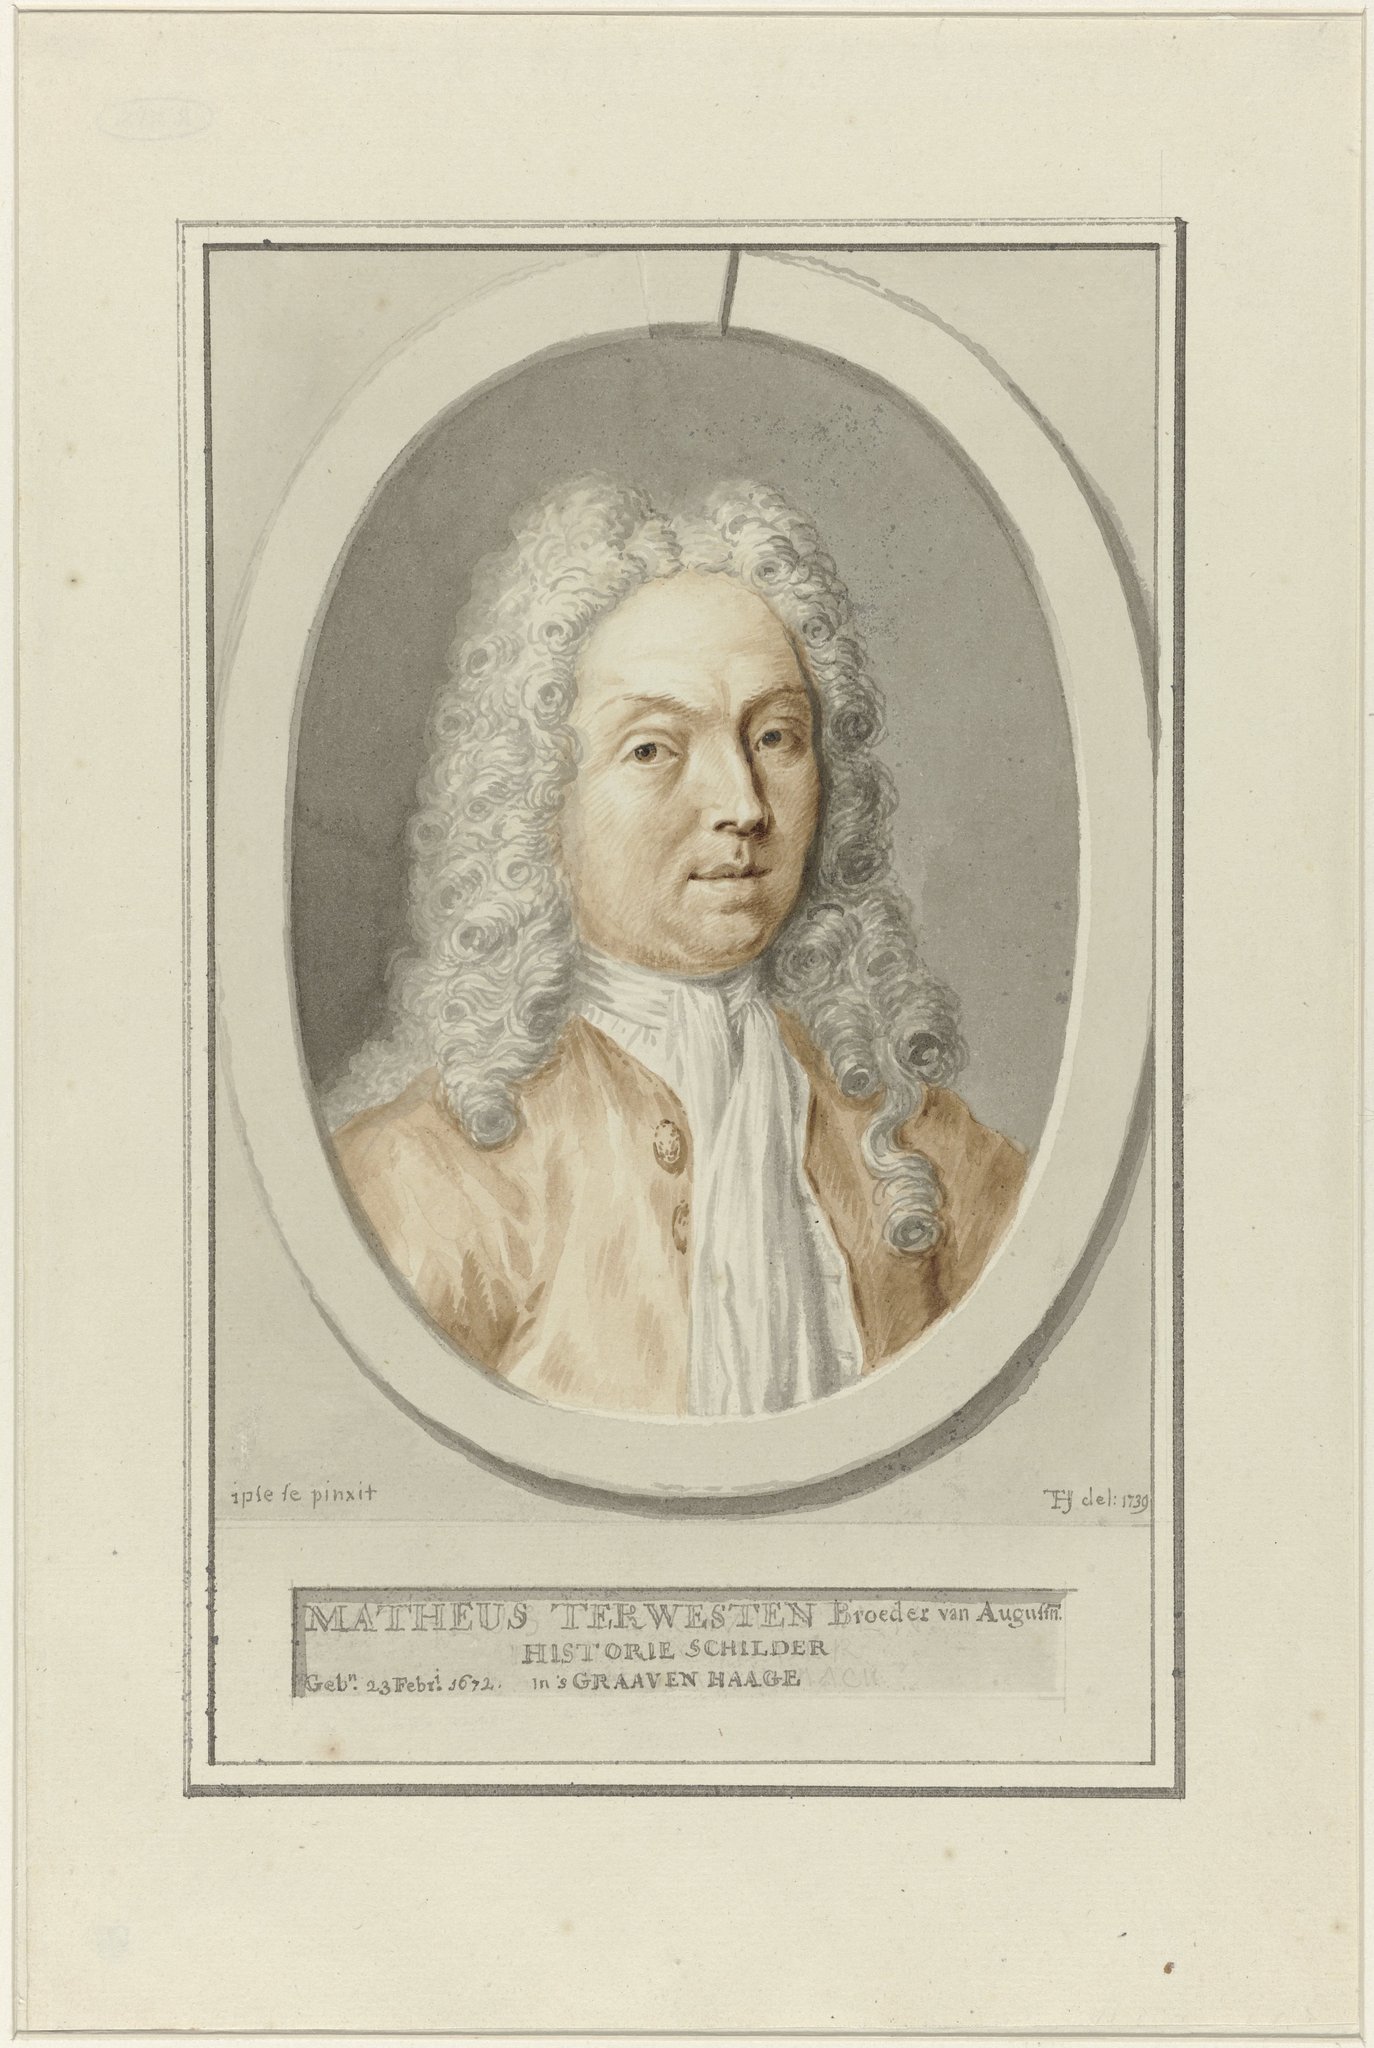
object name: drawing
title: Portret van de schilder Mattheus Terwesten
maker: tako hajo jelgersma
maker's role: draughtsman, painter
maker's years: 1702-1795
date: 1739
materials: paper, pencil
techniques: brush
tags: the hague, painter, draughtsman, mattheus terwesten, historical persons, portrait, self-portrait of painter, portrait, self-portrait of artist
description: Kopie naar zelfportret van de schilder Mattheus Terwesten.